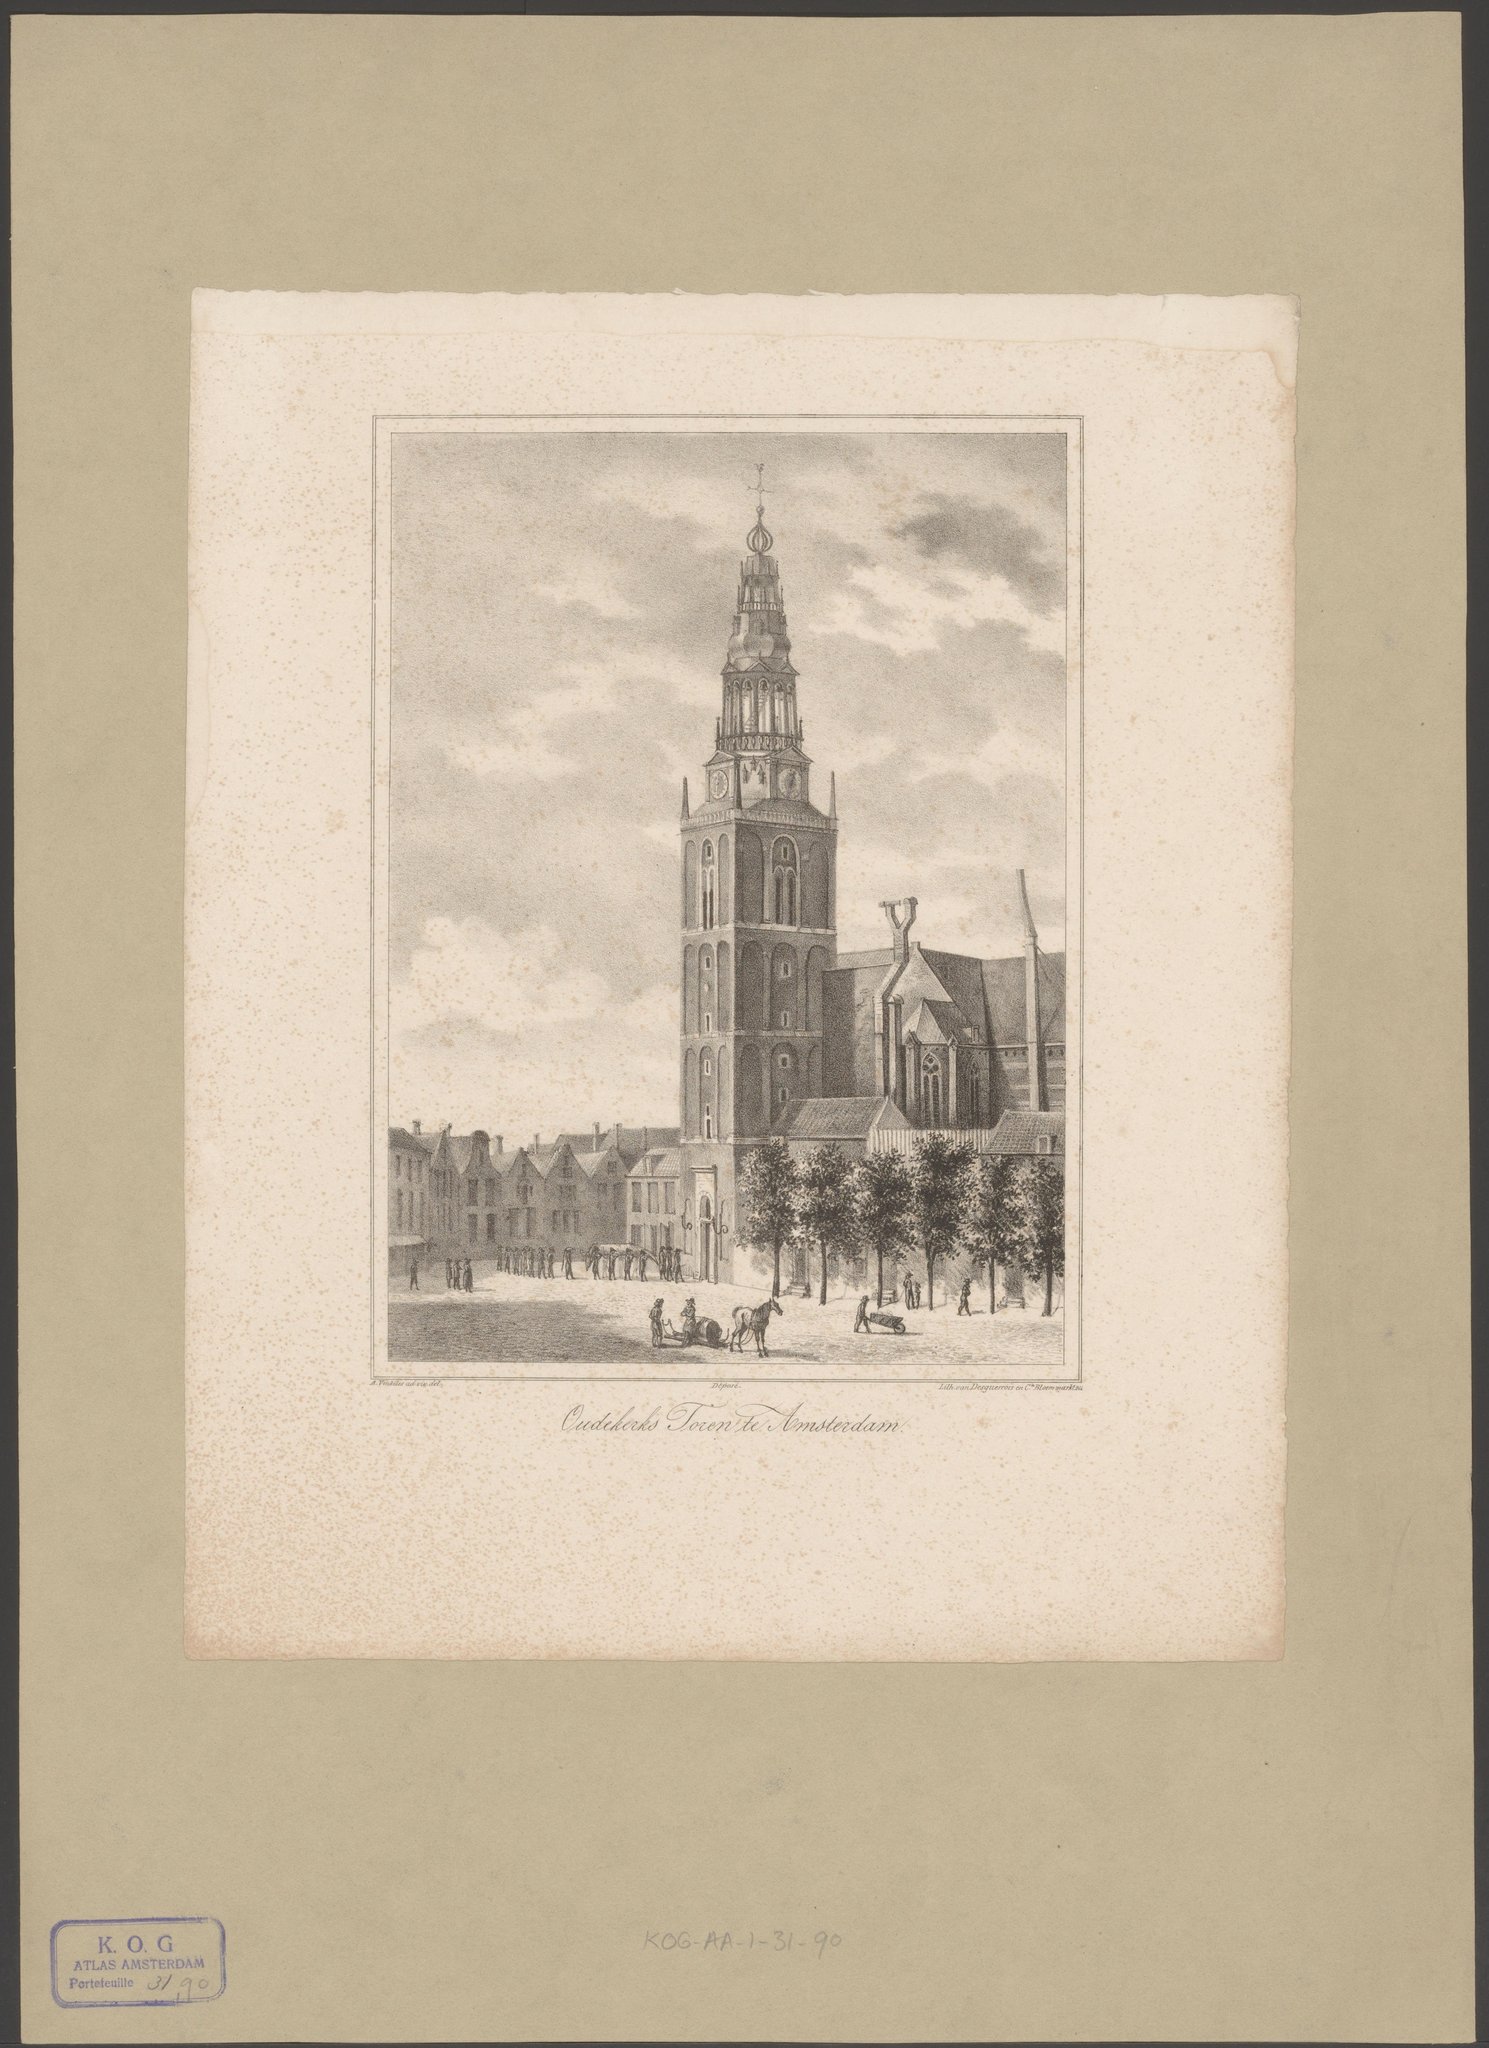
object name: print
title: Gezichten van de Zes Voornaamste Torens der Stad Amsterdam. 2de Cahier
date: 1828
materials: paper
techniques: lithograph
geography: amsterdam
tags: tower, clock tower ~ monumental adornment, church (exterior), horse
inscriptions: collector's mark: ‘31.90’ Lugt 1641b, : ‘Déposé’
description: Onderwerpsrubriek binnen de Atlas Amsterdam: Kerkwezen: Hervormde Gemeente: Oude Kerk van buiten.